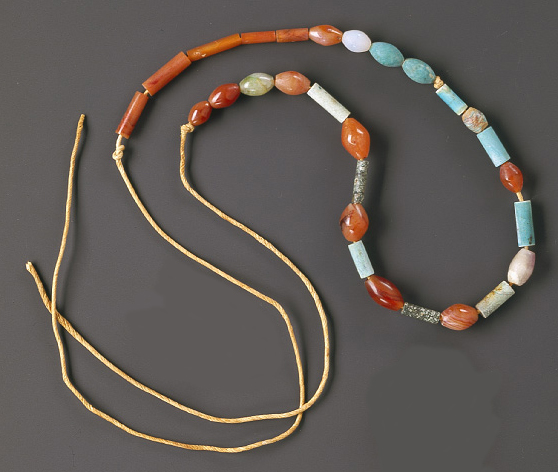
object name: necklace, bead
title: Necklace of Wah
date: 1981-1975 BCE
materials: stone, gemstone, cord, linen, quartz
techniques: glazing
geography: egypt